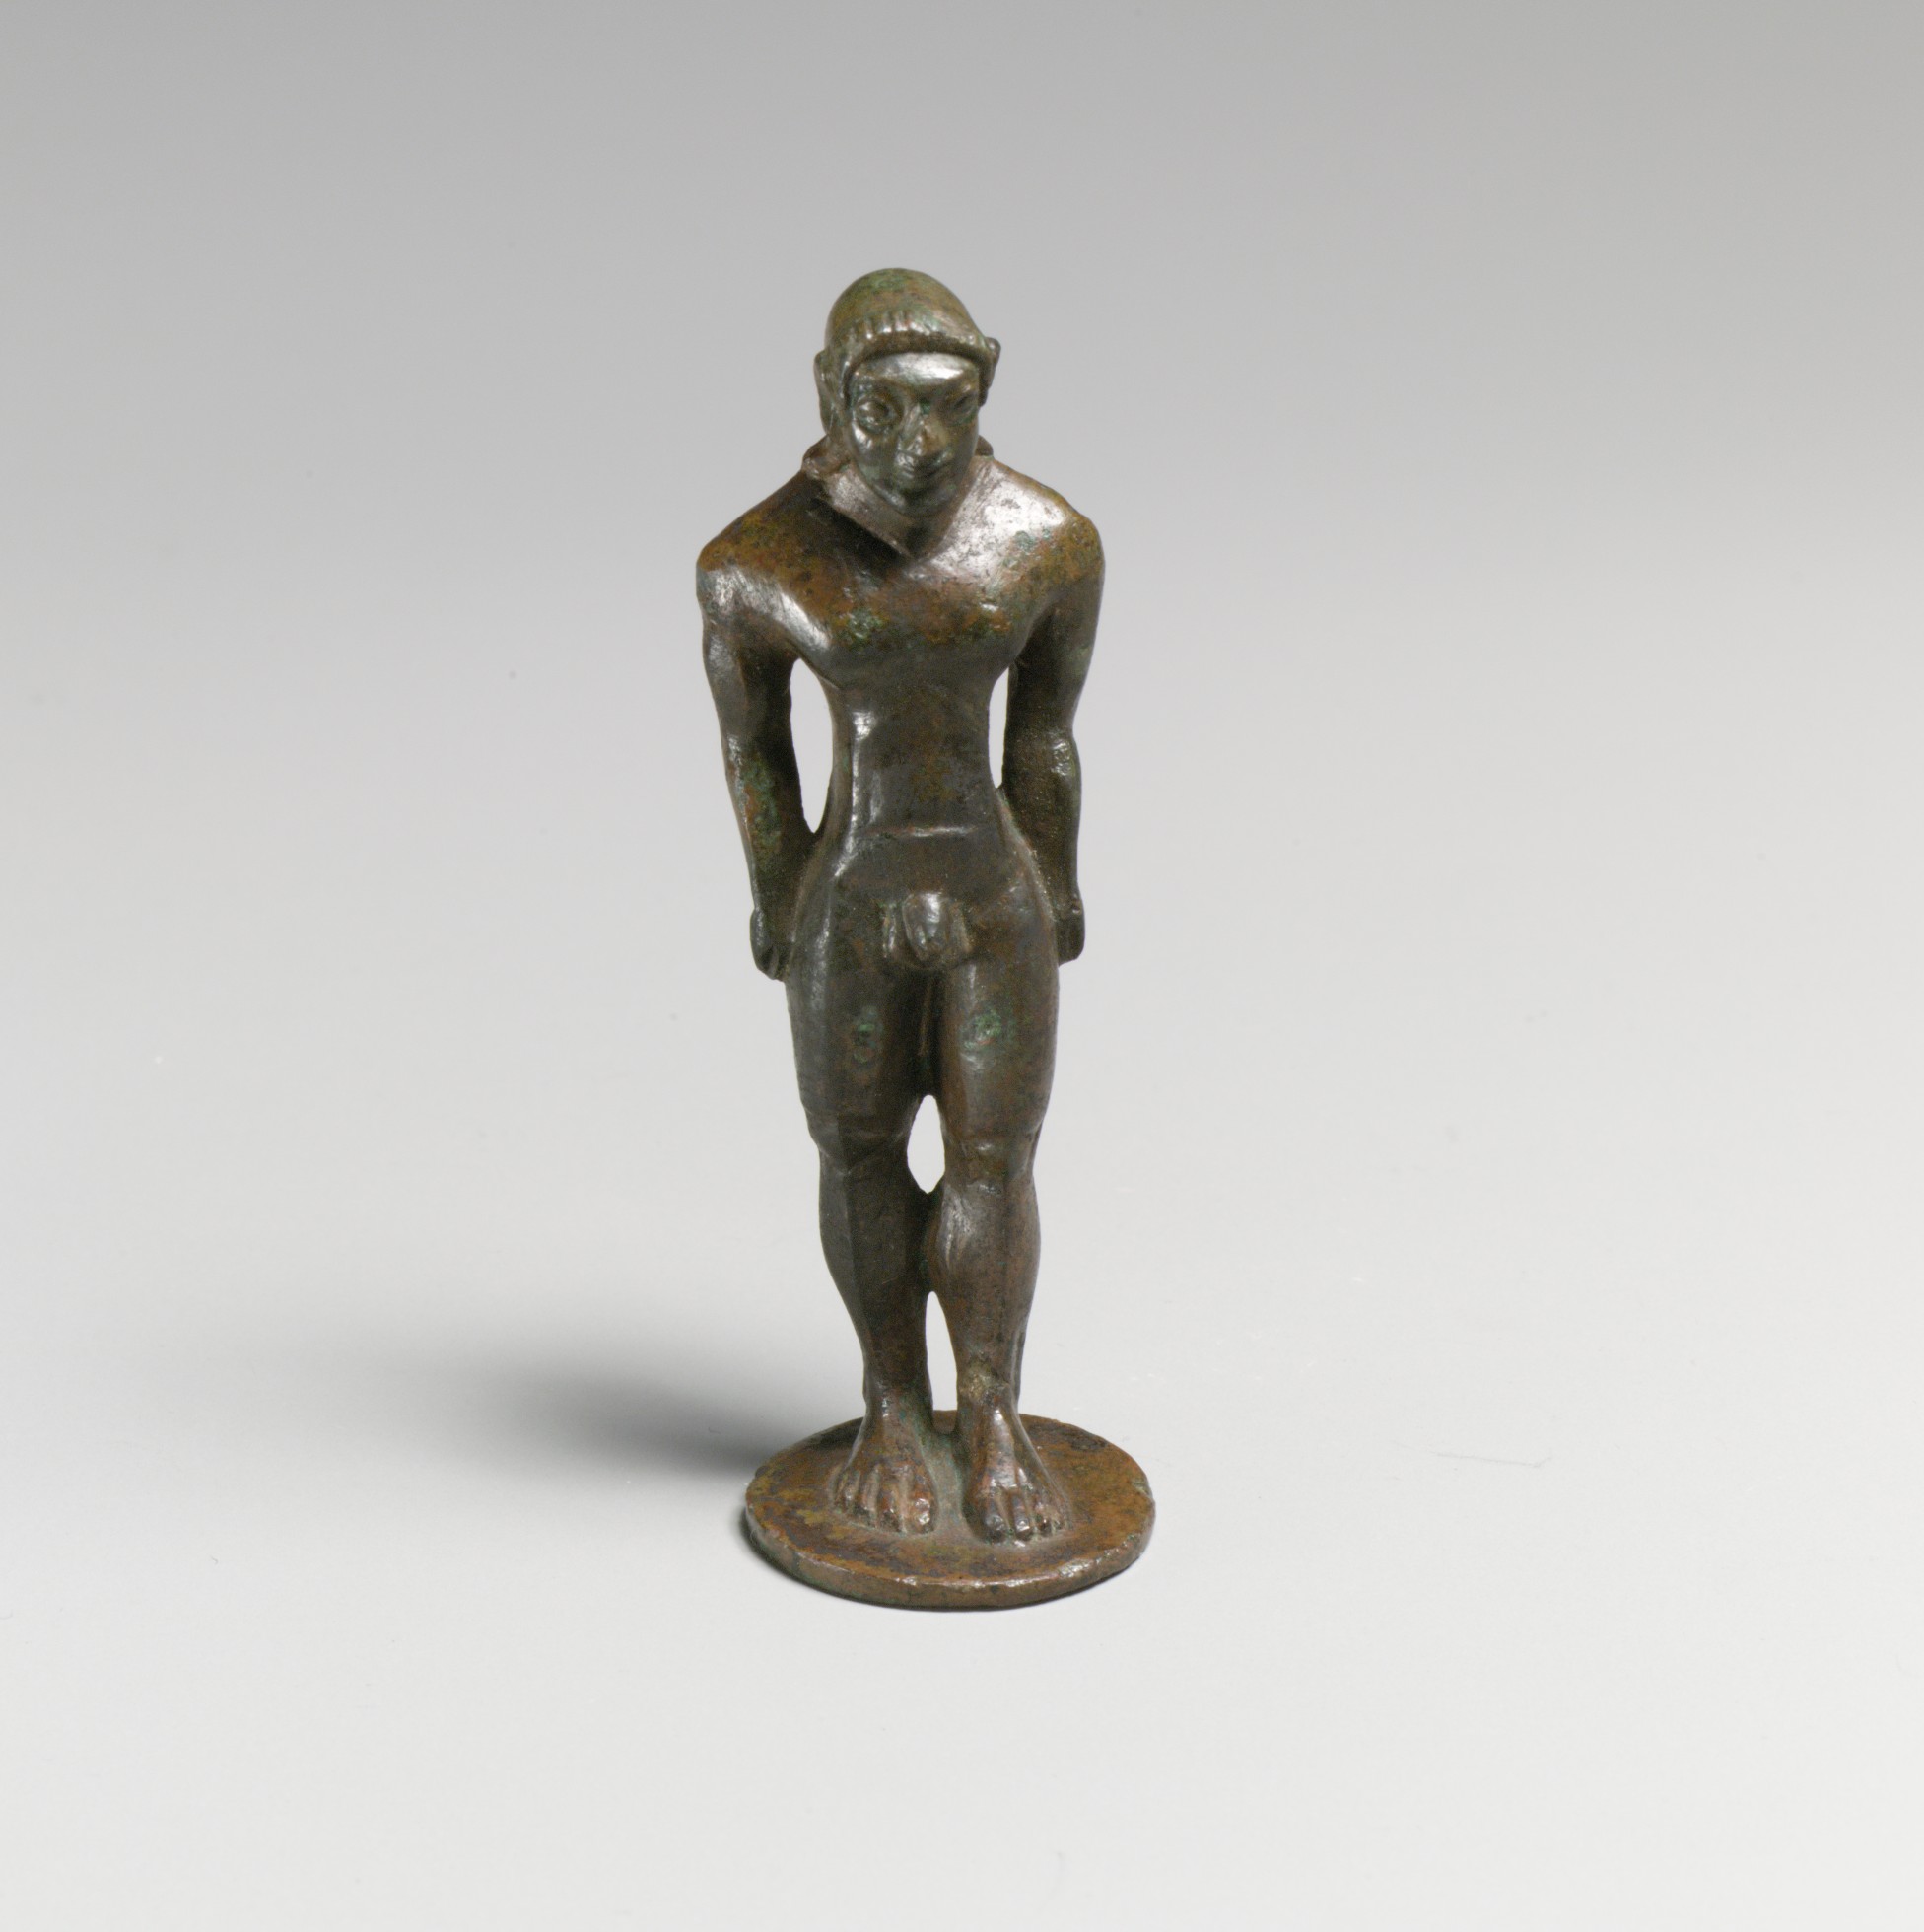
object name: statuette of a youth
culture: etruscan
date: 600-501 BCE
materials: bronze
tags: male nudes